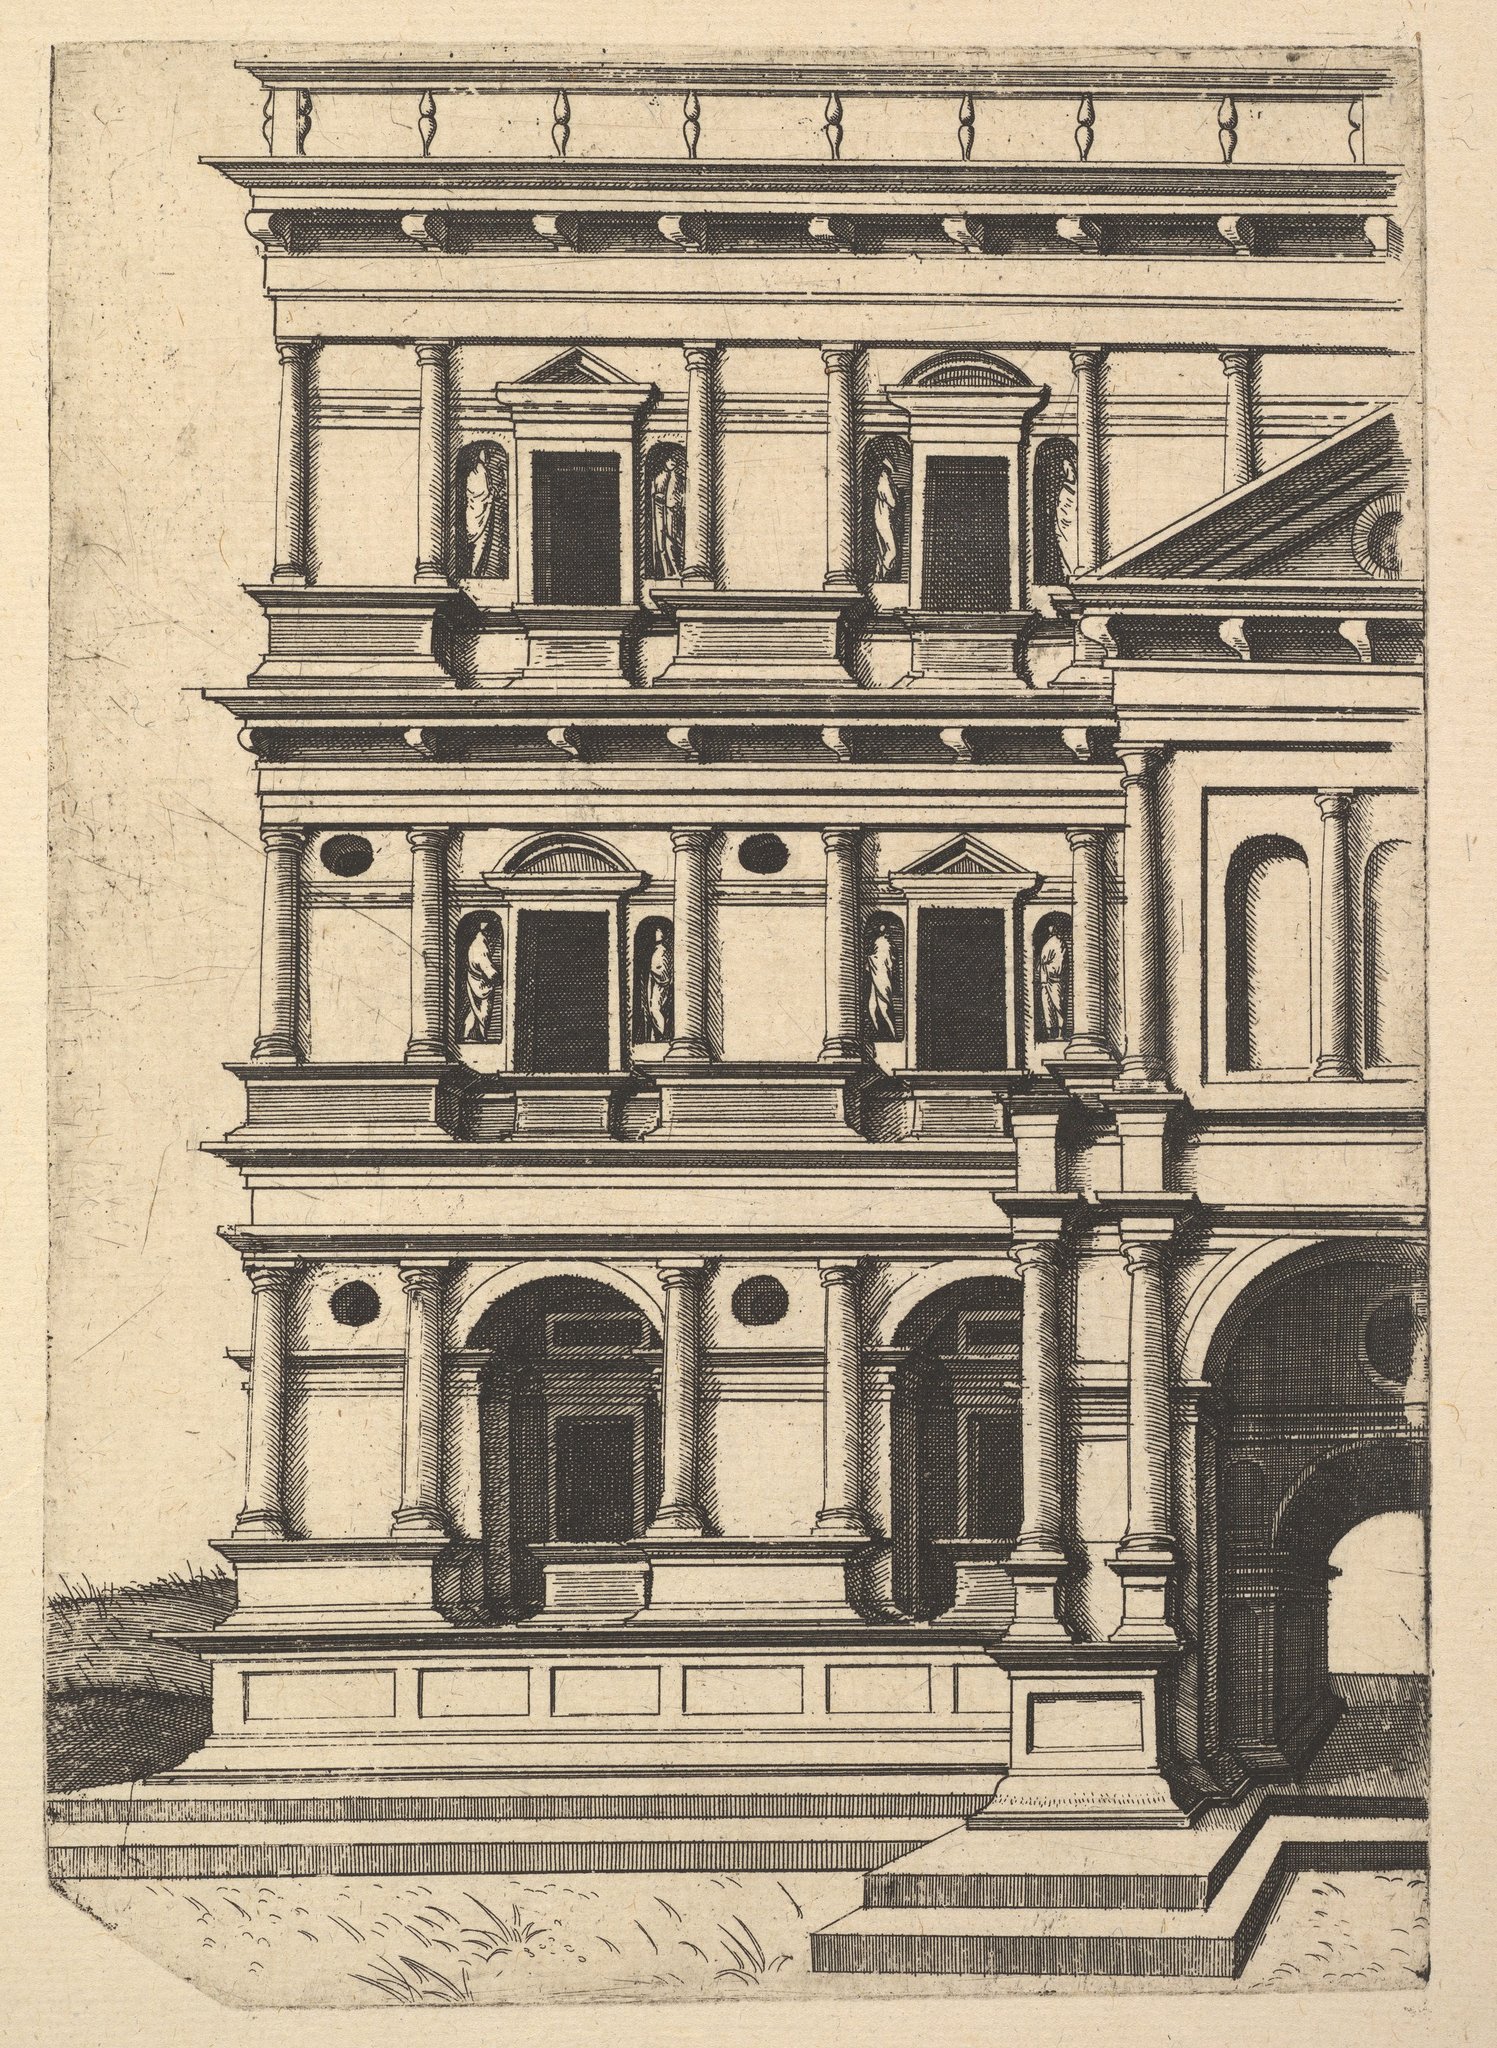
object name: book print ornament architecture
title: Partial View of a Building [Palatium Claudie] from the series 'Ruinarum variarum fabricarum delineationes pictoribus caeterisque id genus artificibus multum utiles'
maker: lambert suavius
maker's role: artist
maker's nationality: netherlandish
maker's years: 1510-1576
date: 1554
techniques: etching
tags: architecture,buildings